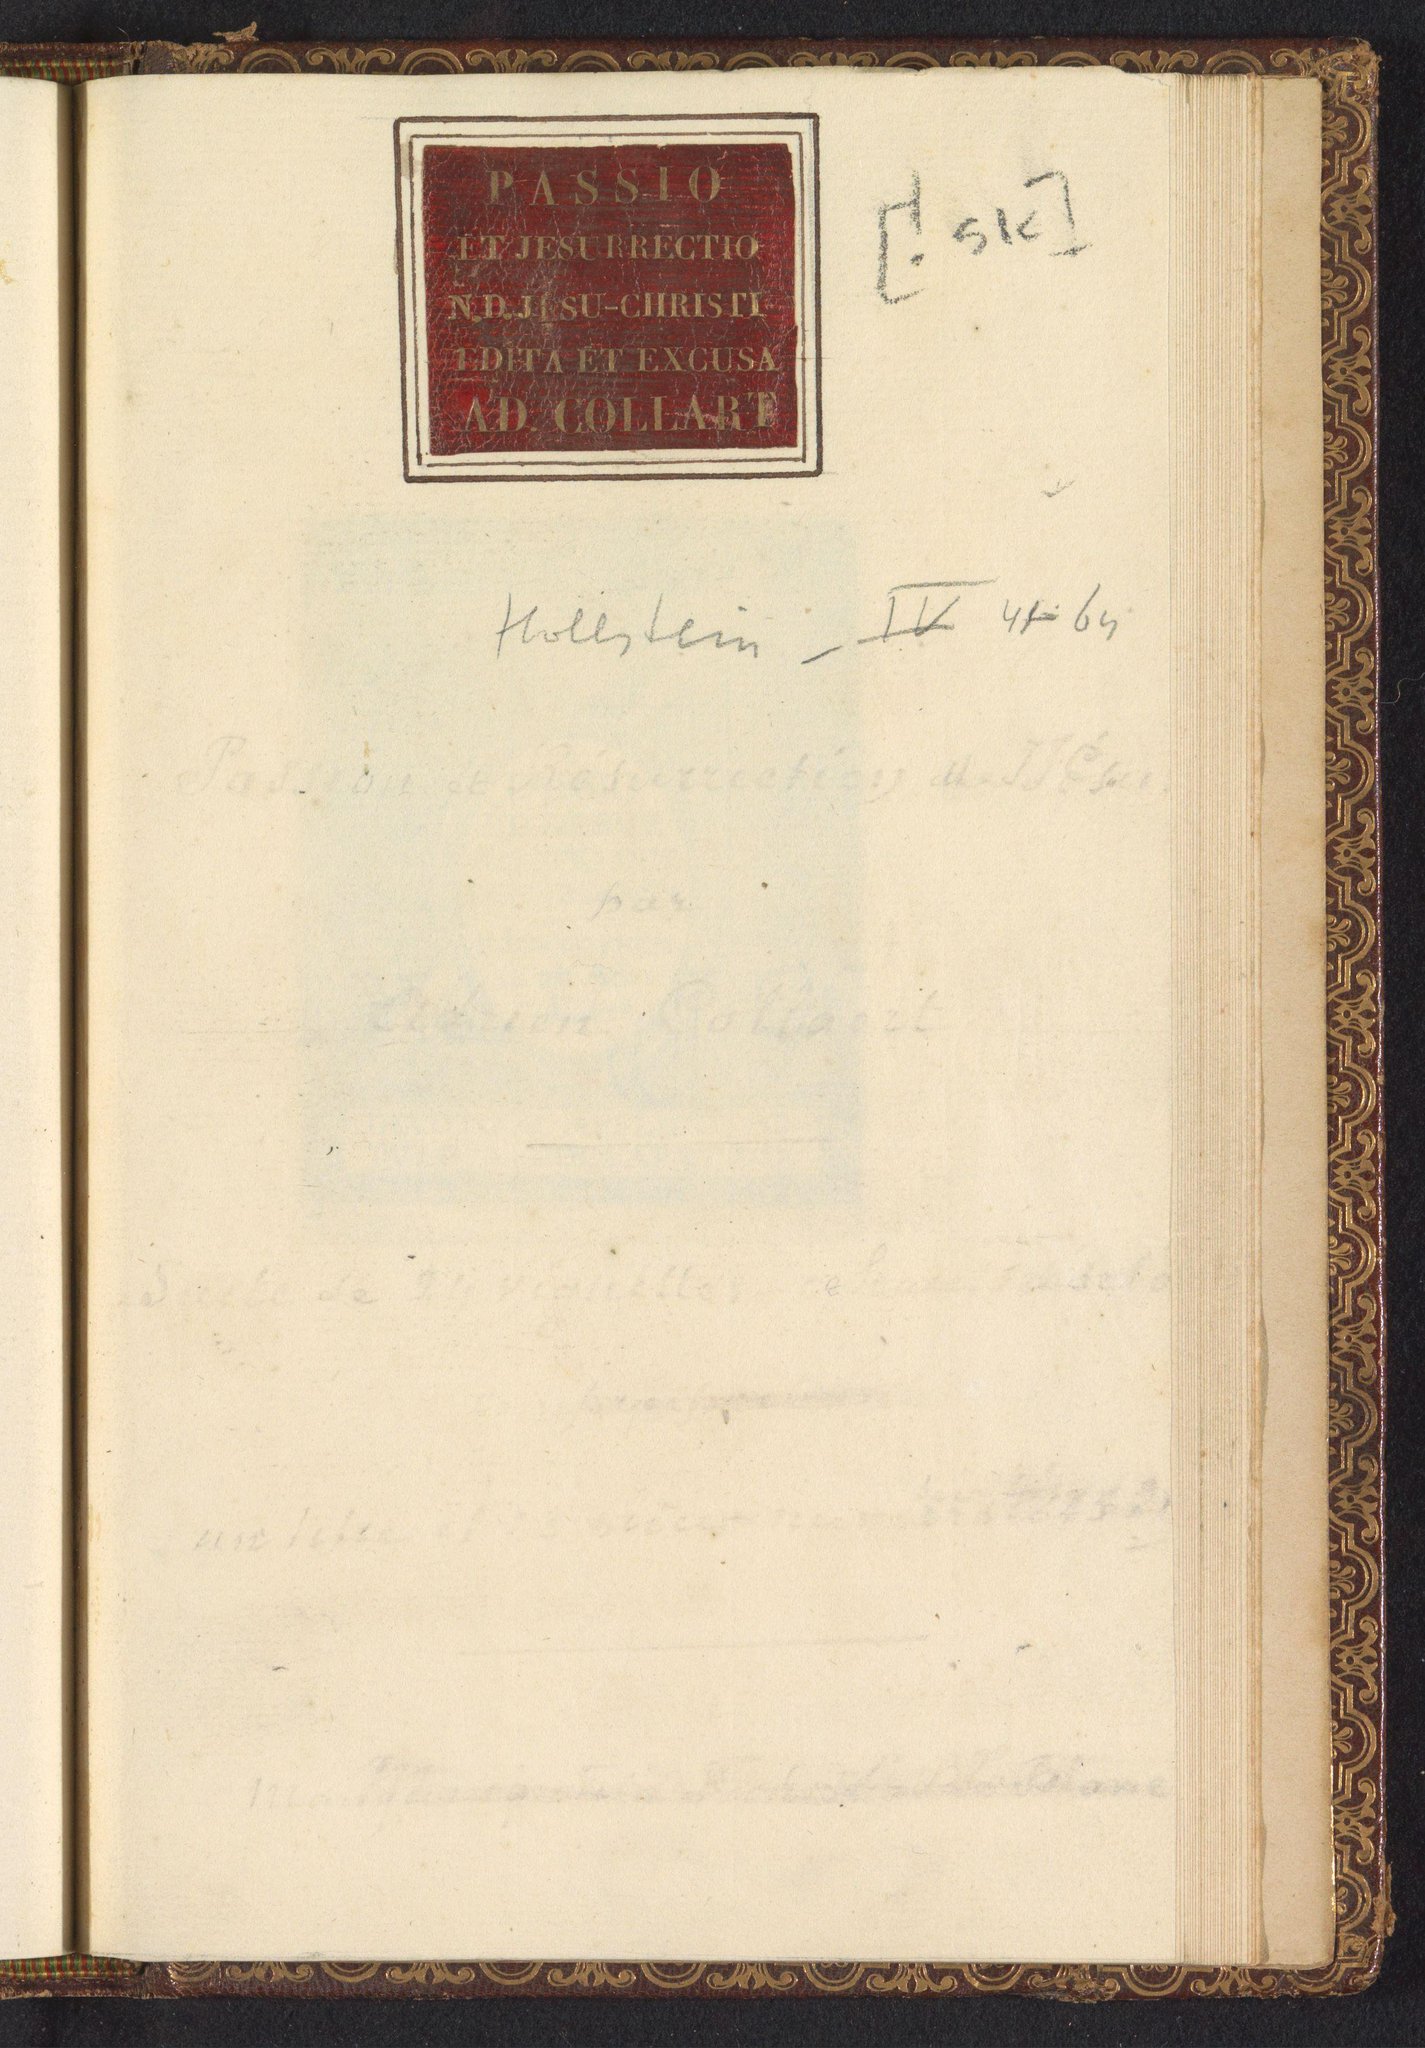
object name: tekst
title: Gedrukte titel: Passio et Jesurrectio N.D. Jesu-Christi edita et excusa Ad. Collart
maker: Anonymous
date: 1580-1590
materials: gold, leather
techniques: letterpress printing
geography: antwerp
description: Op leer gedrukte titel in gouddruk: Passio et Jesurrectio N.D. Jesu-Christi edita et excusa Ad. Collart. Onderdeel van de prentserie over de passie van Christus: Passio et resurrectio D.N. Iesu Christi. Edita et excusa ab Ad. Collaert. In prentalbum met twee reeksen van respectievelijk 34 en 25 gravures met scènes uit het leven en het lijdensverhaal van Christus.